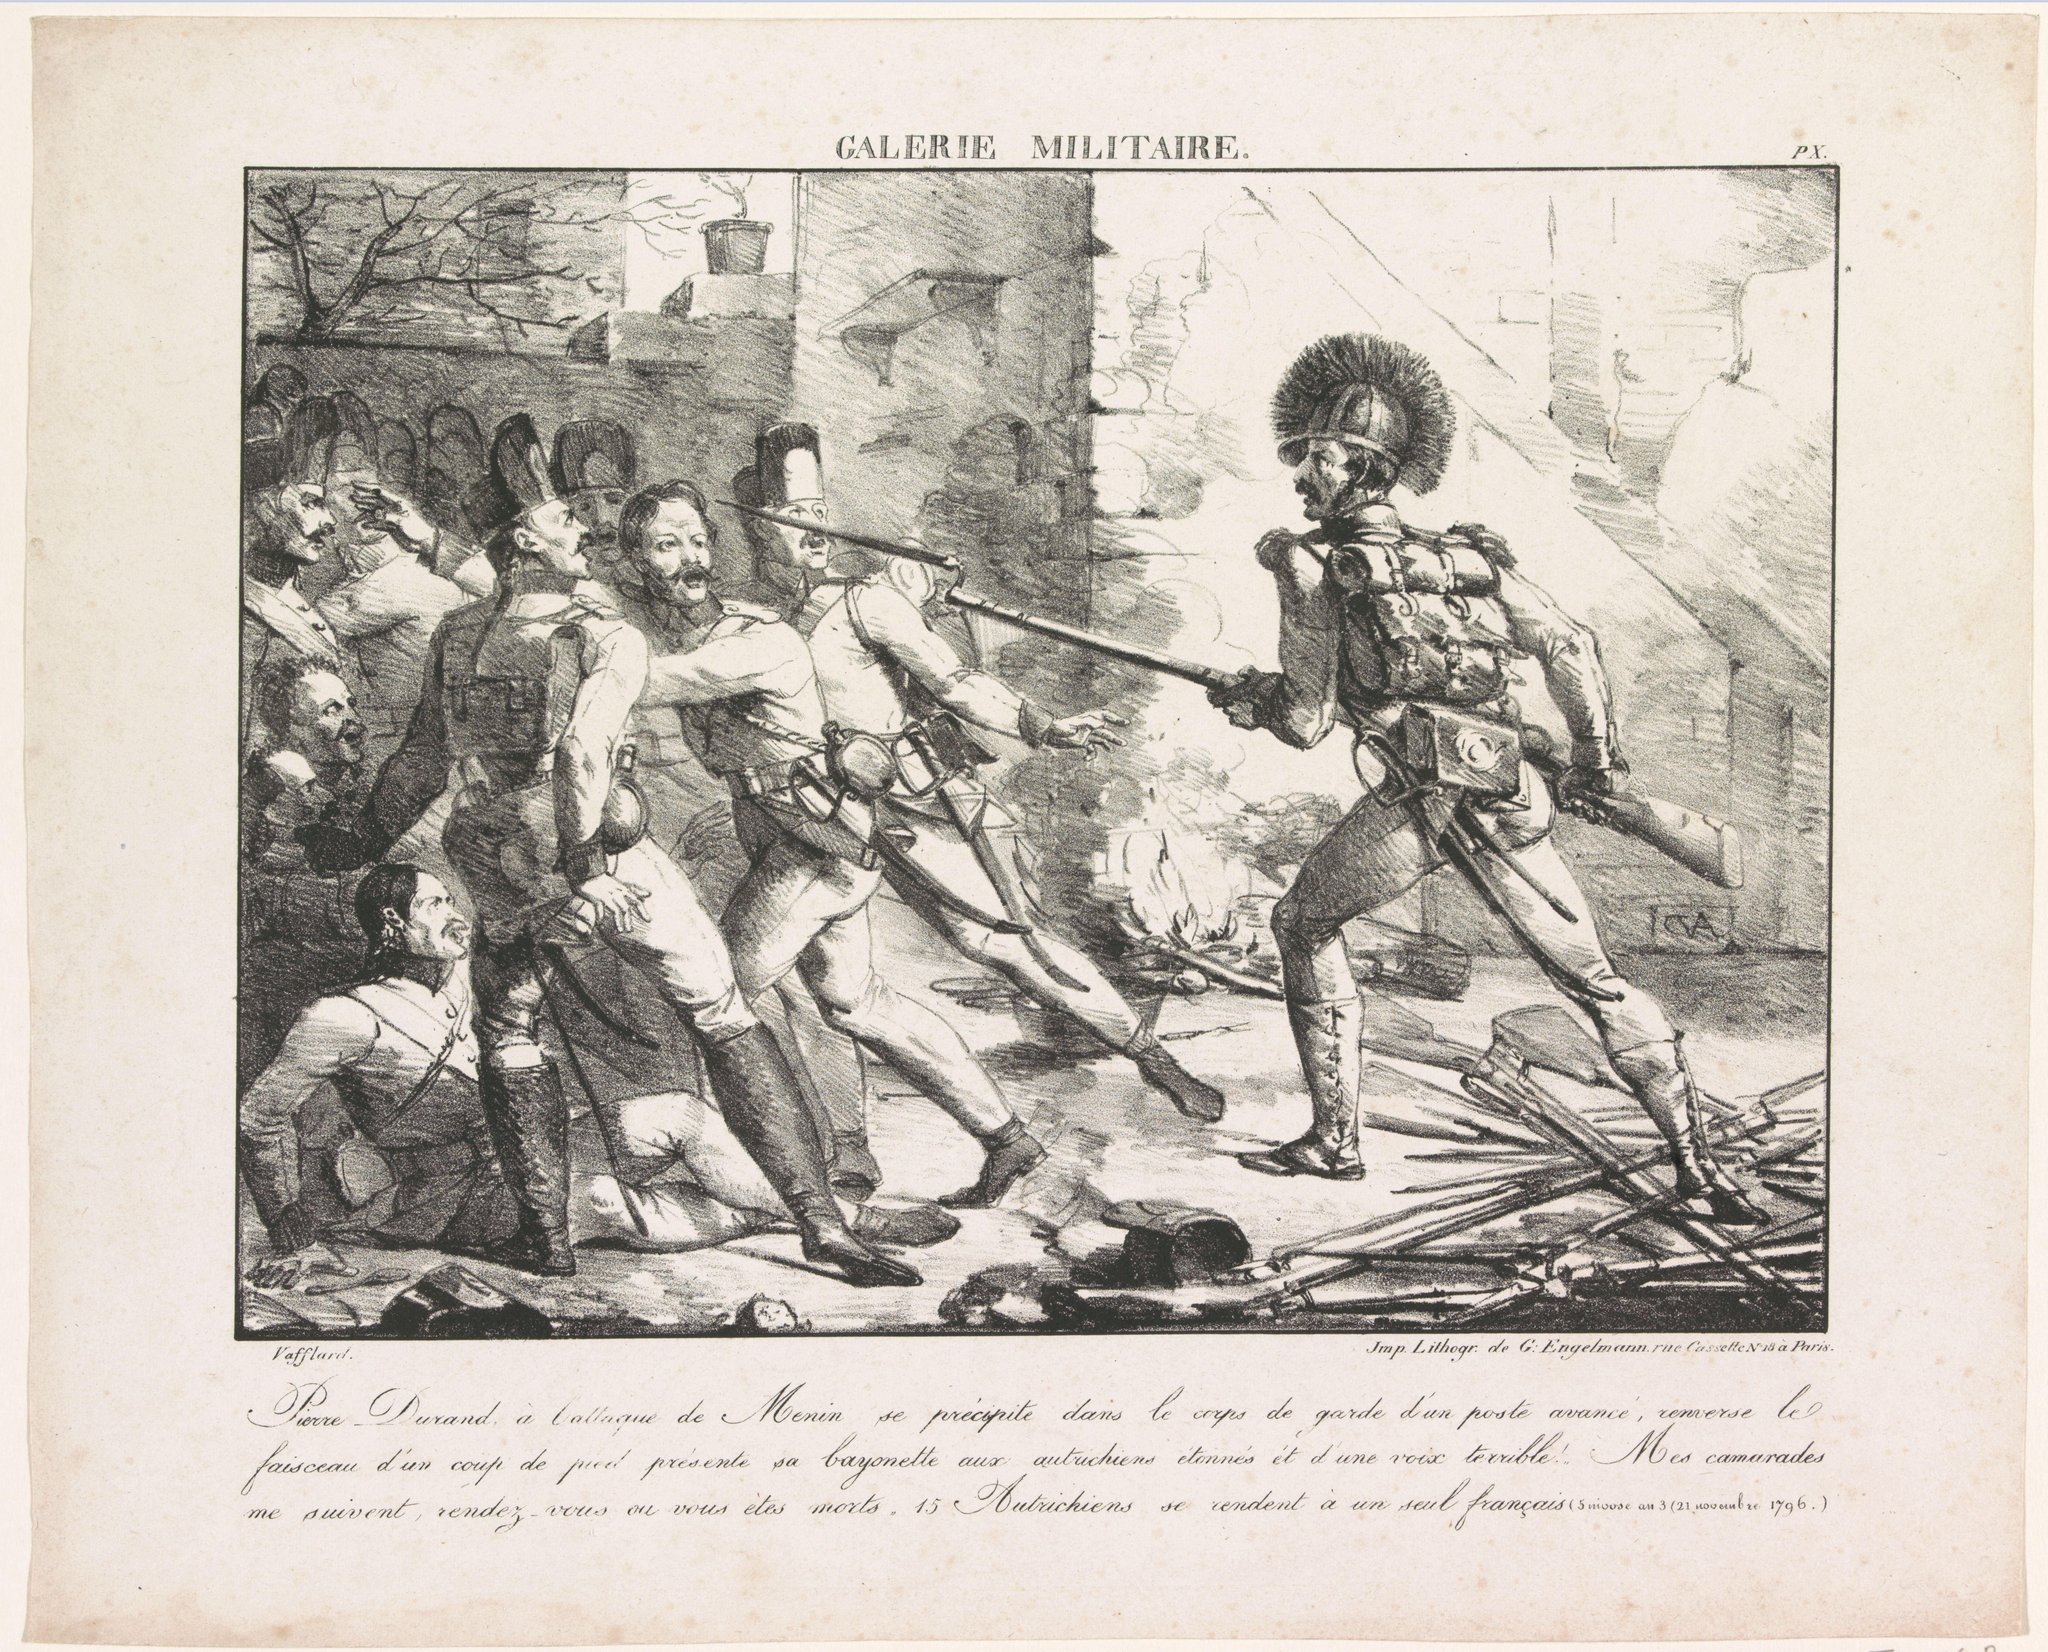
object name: print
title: Pierre Durand overrompelt een voorpost van de Oostenrijkers, 1796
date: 1818-1819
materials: paper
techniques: lithograph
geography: france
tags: battle (+ land forces)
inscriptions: collector's mark: Lugt 2228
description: Niet in Frederik Muller; door het RPK toegevoegd nummer. Uitgegeven in de reeks: Galerie Militaire (ou Galerie des Militaires français qui, à différentes épouques, se sont signalés par leur courage), G. Engelmann, Parijs 1818-1819.